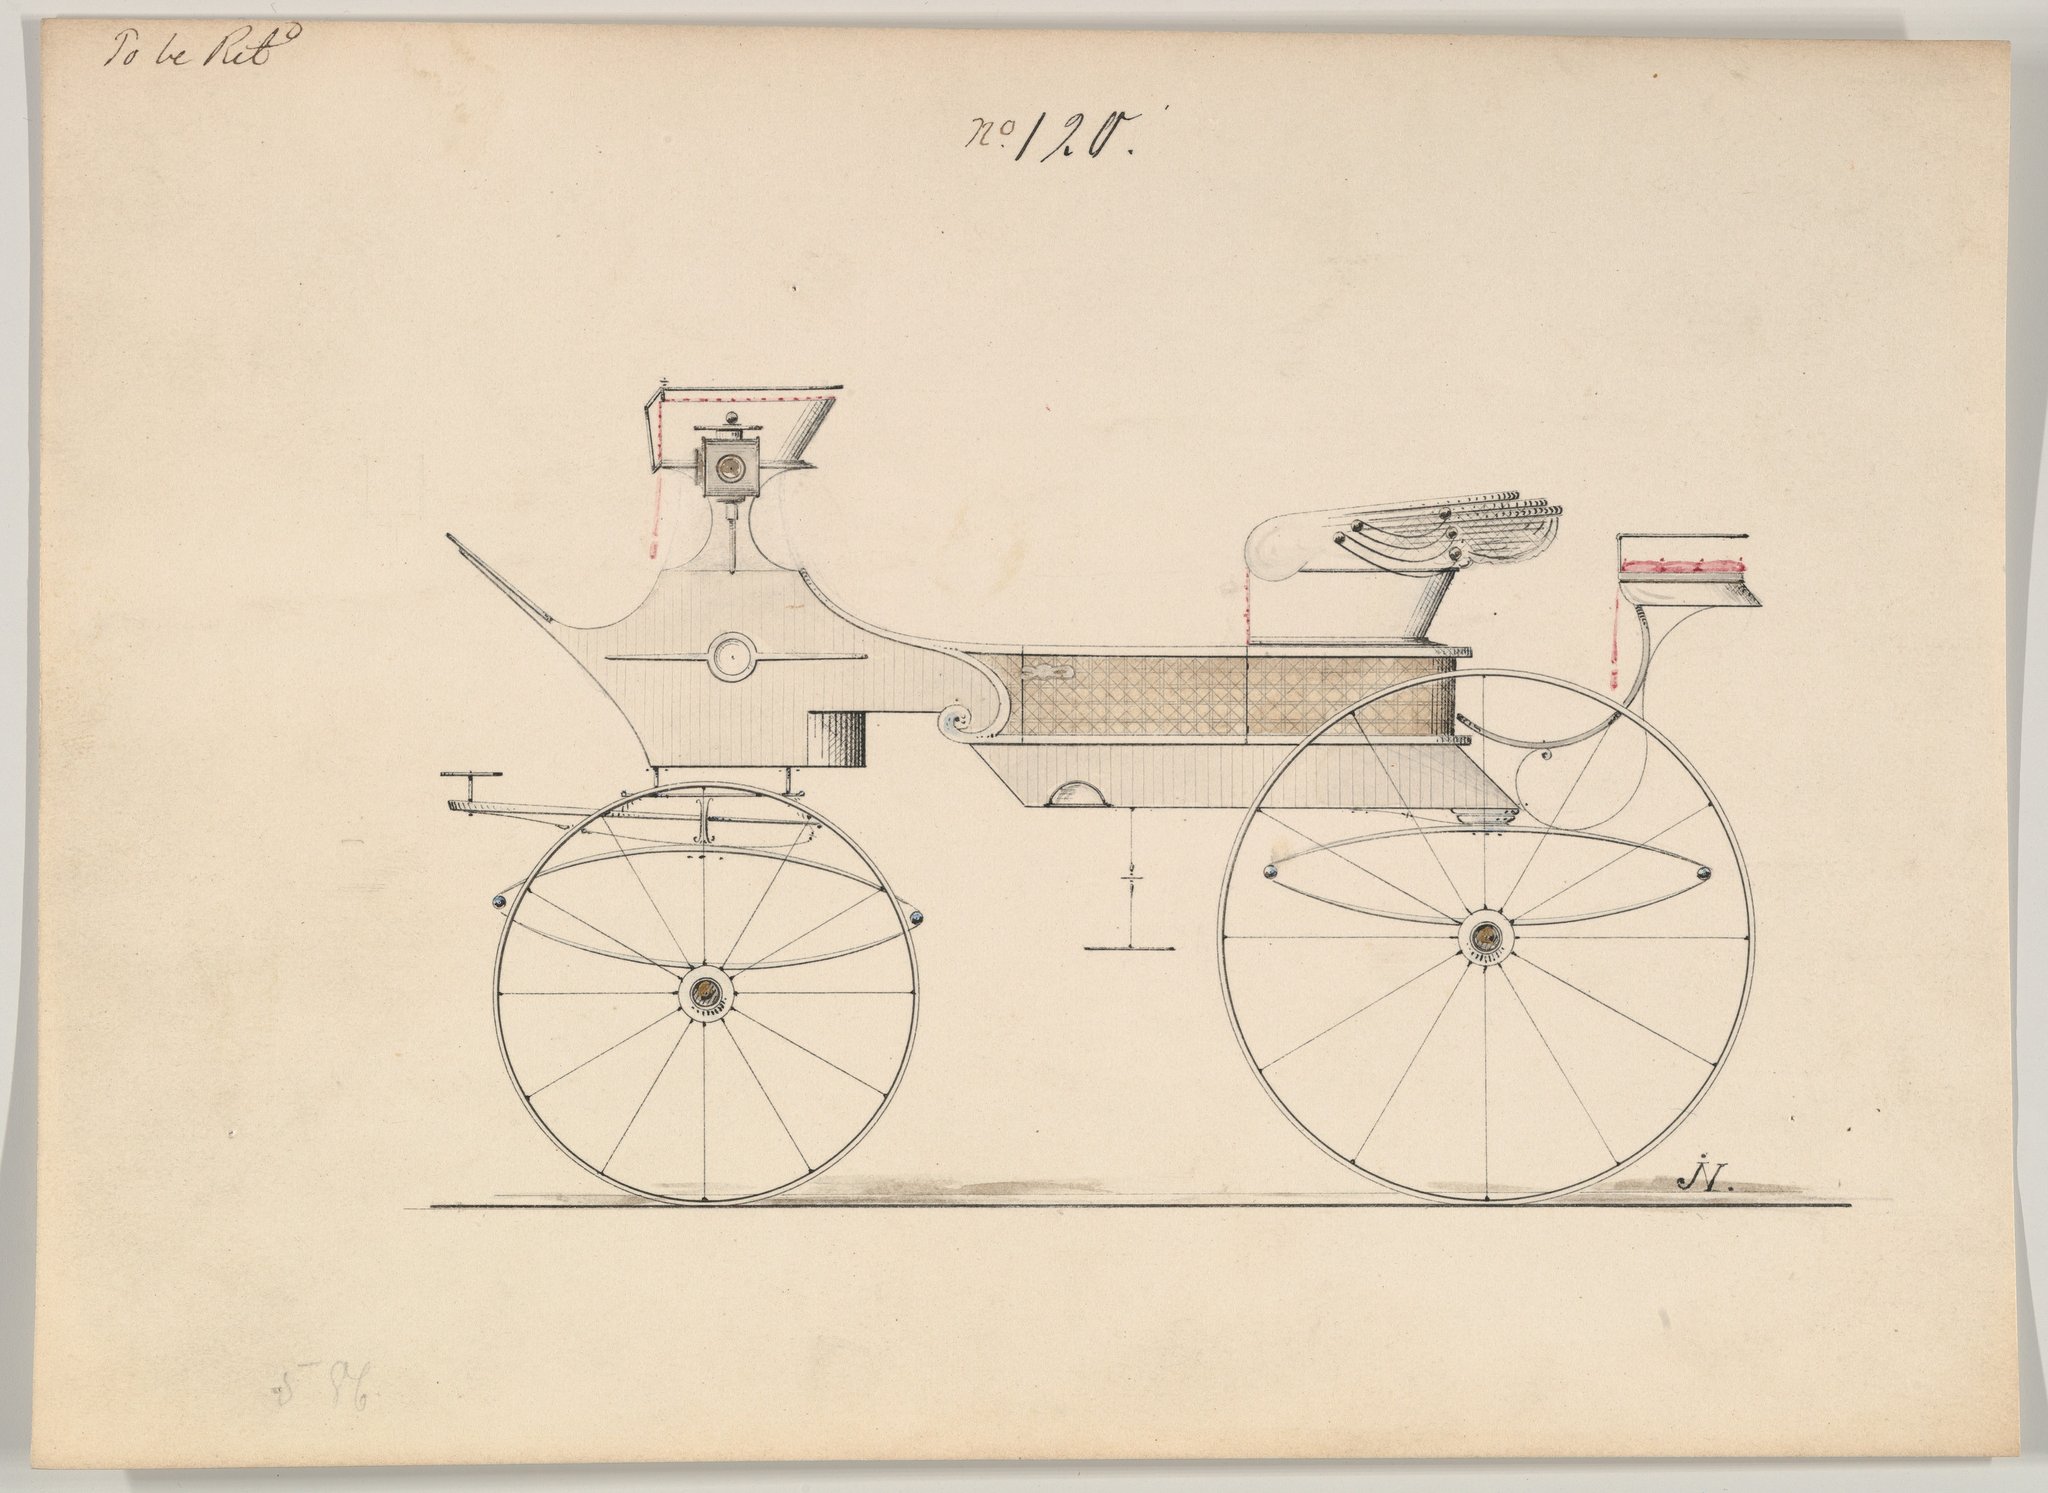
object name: drawing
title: Drag #120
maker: brewster & co.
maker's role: manufacturer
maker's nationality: american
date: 1850-1870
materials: graphite, ink, watercolor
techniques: pen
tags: carriages